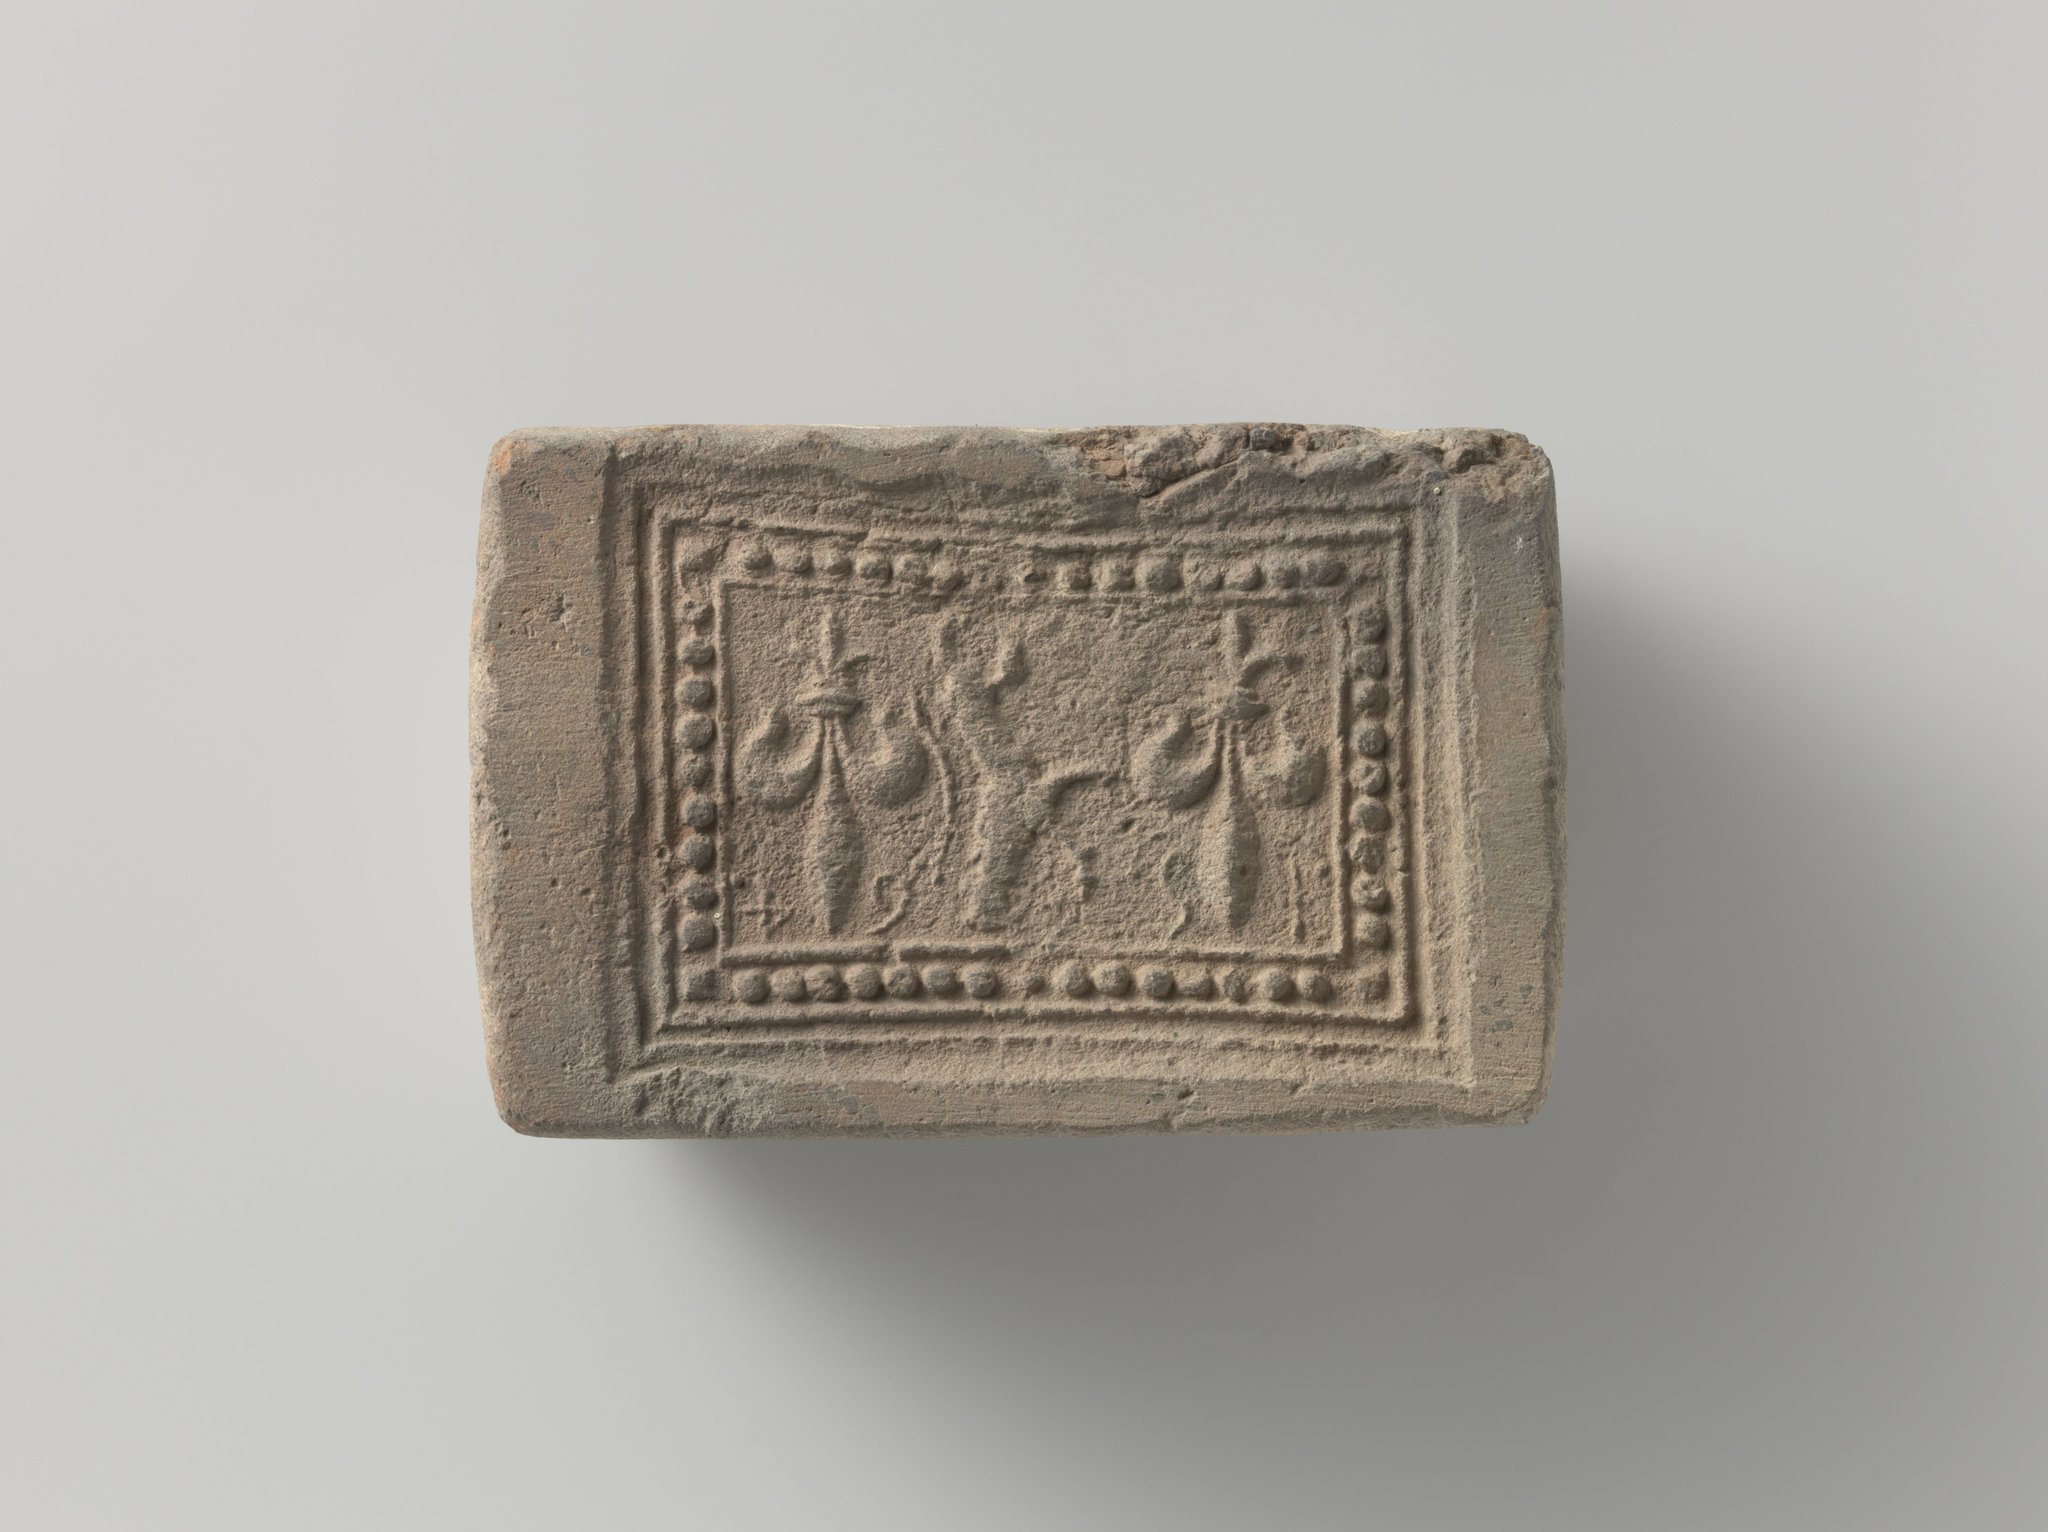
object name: hearthstone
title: Haardsteen, waarop een klimmende leeuw tussen twee lelies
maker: Anonymous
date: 1564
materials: earthenware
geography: southern netherlands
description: Haardsteen, waarop een klimmende leeuw tussen twee lelies en het jaar 1564. Georneerde rand. Van fijne gebakken aarde.